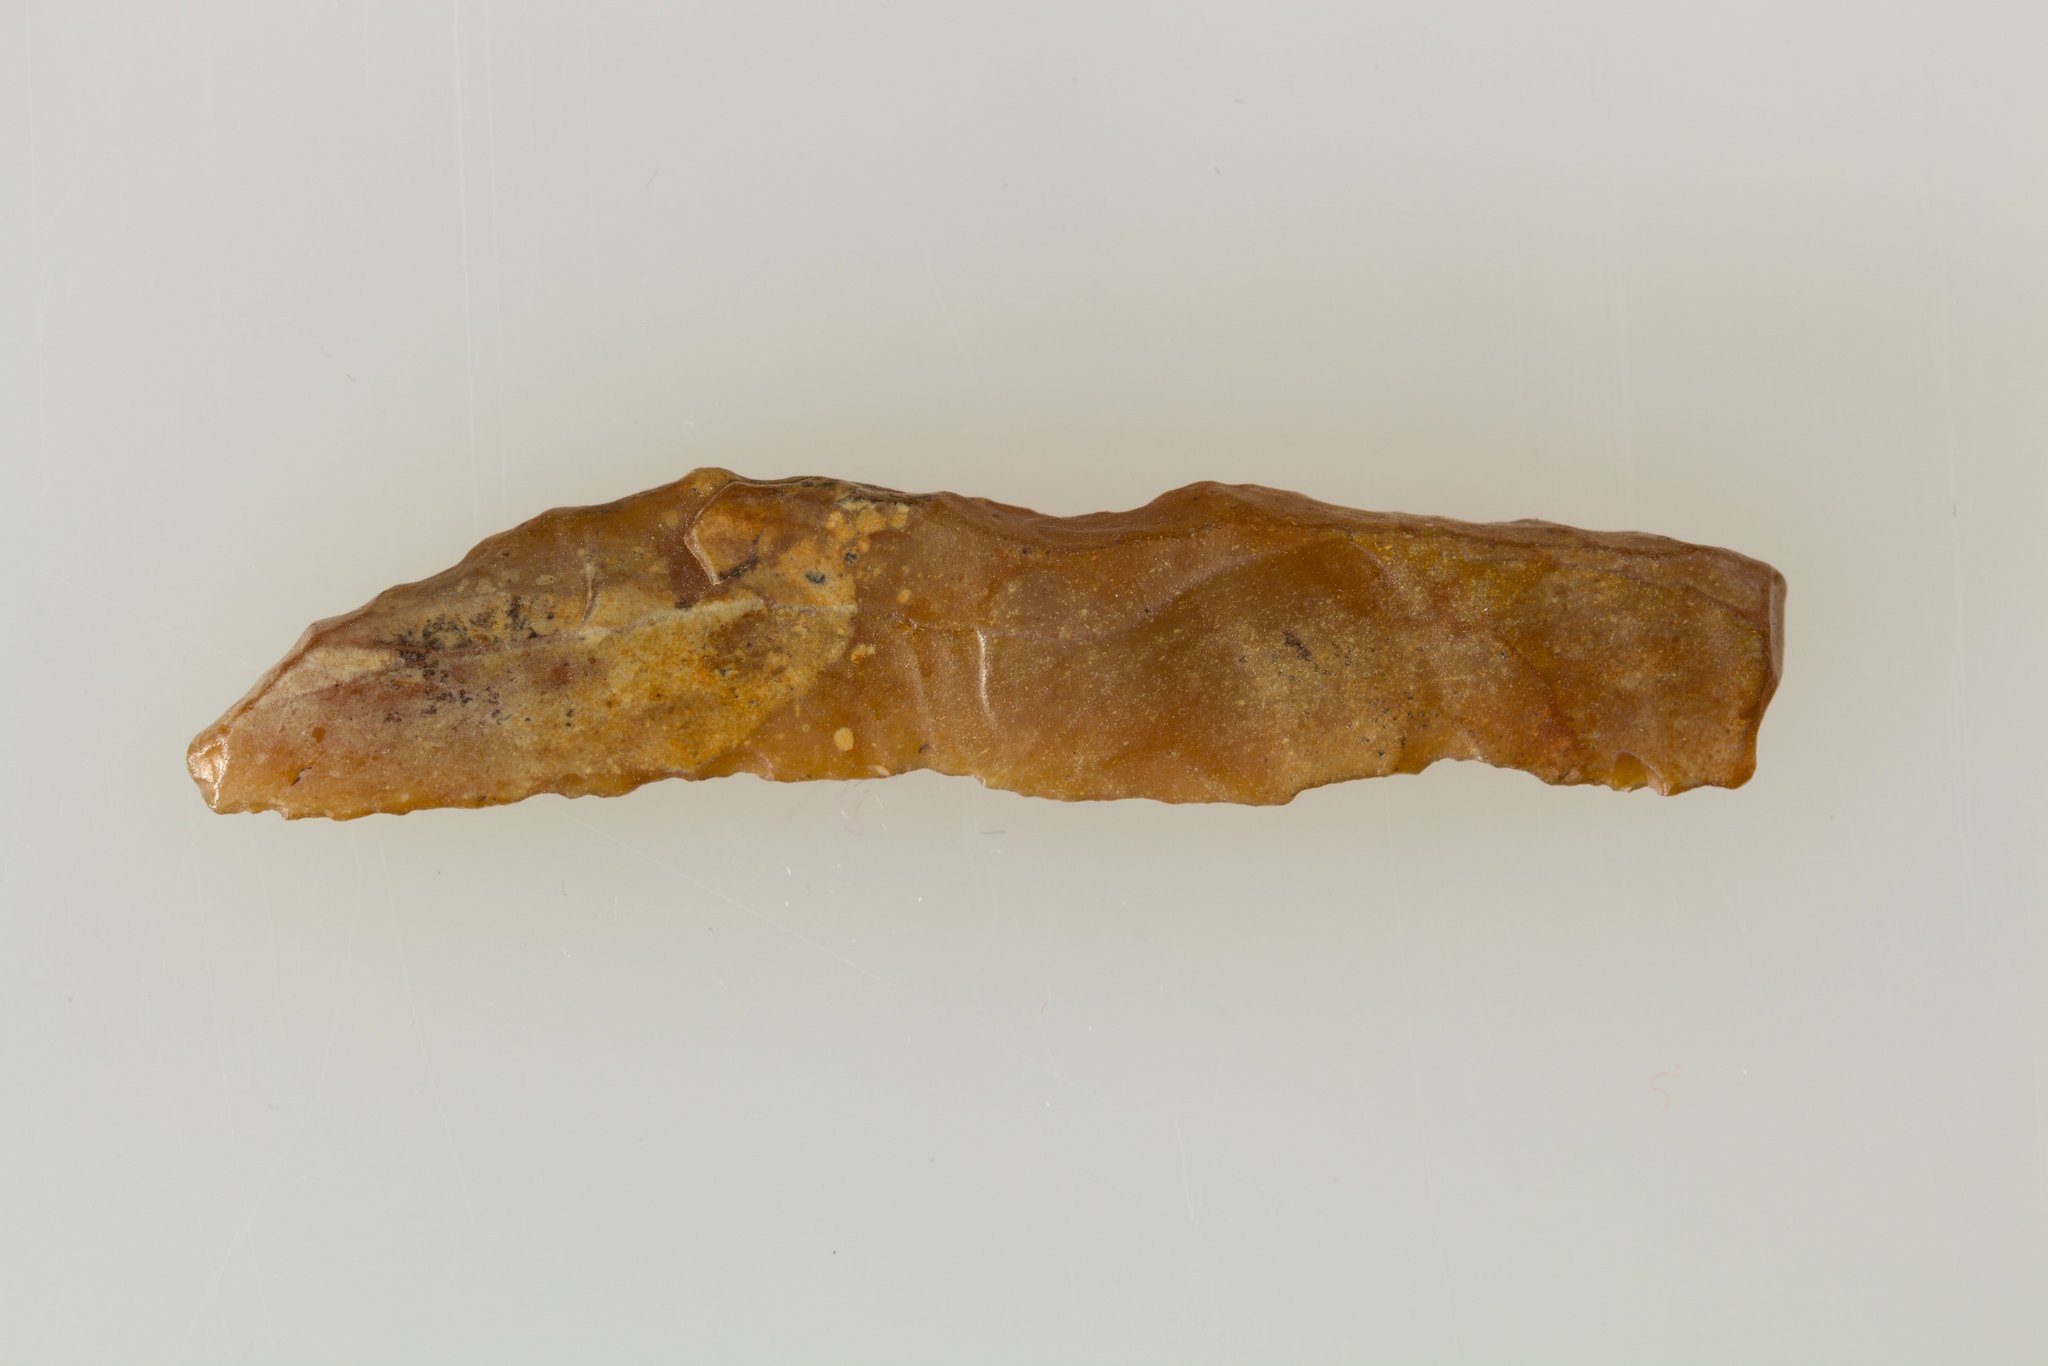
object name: tool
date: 3850-2960 BCE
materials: stone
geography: egypt